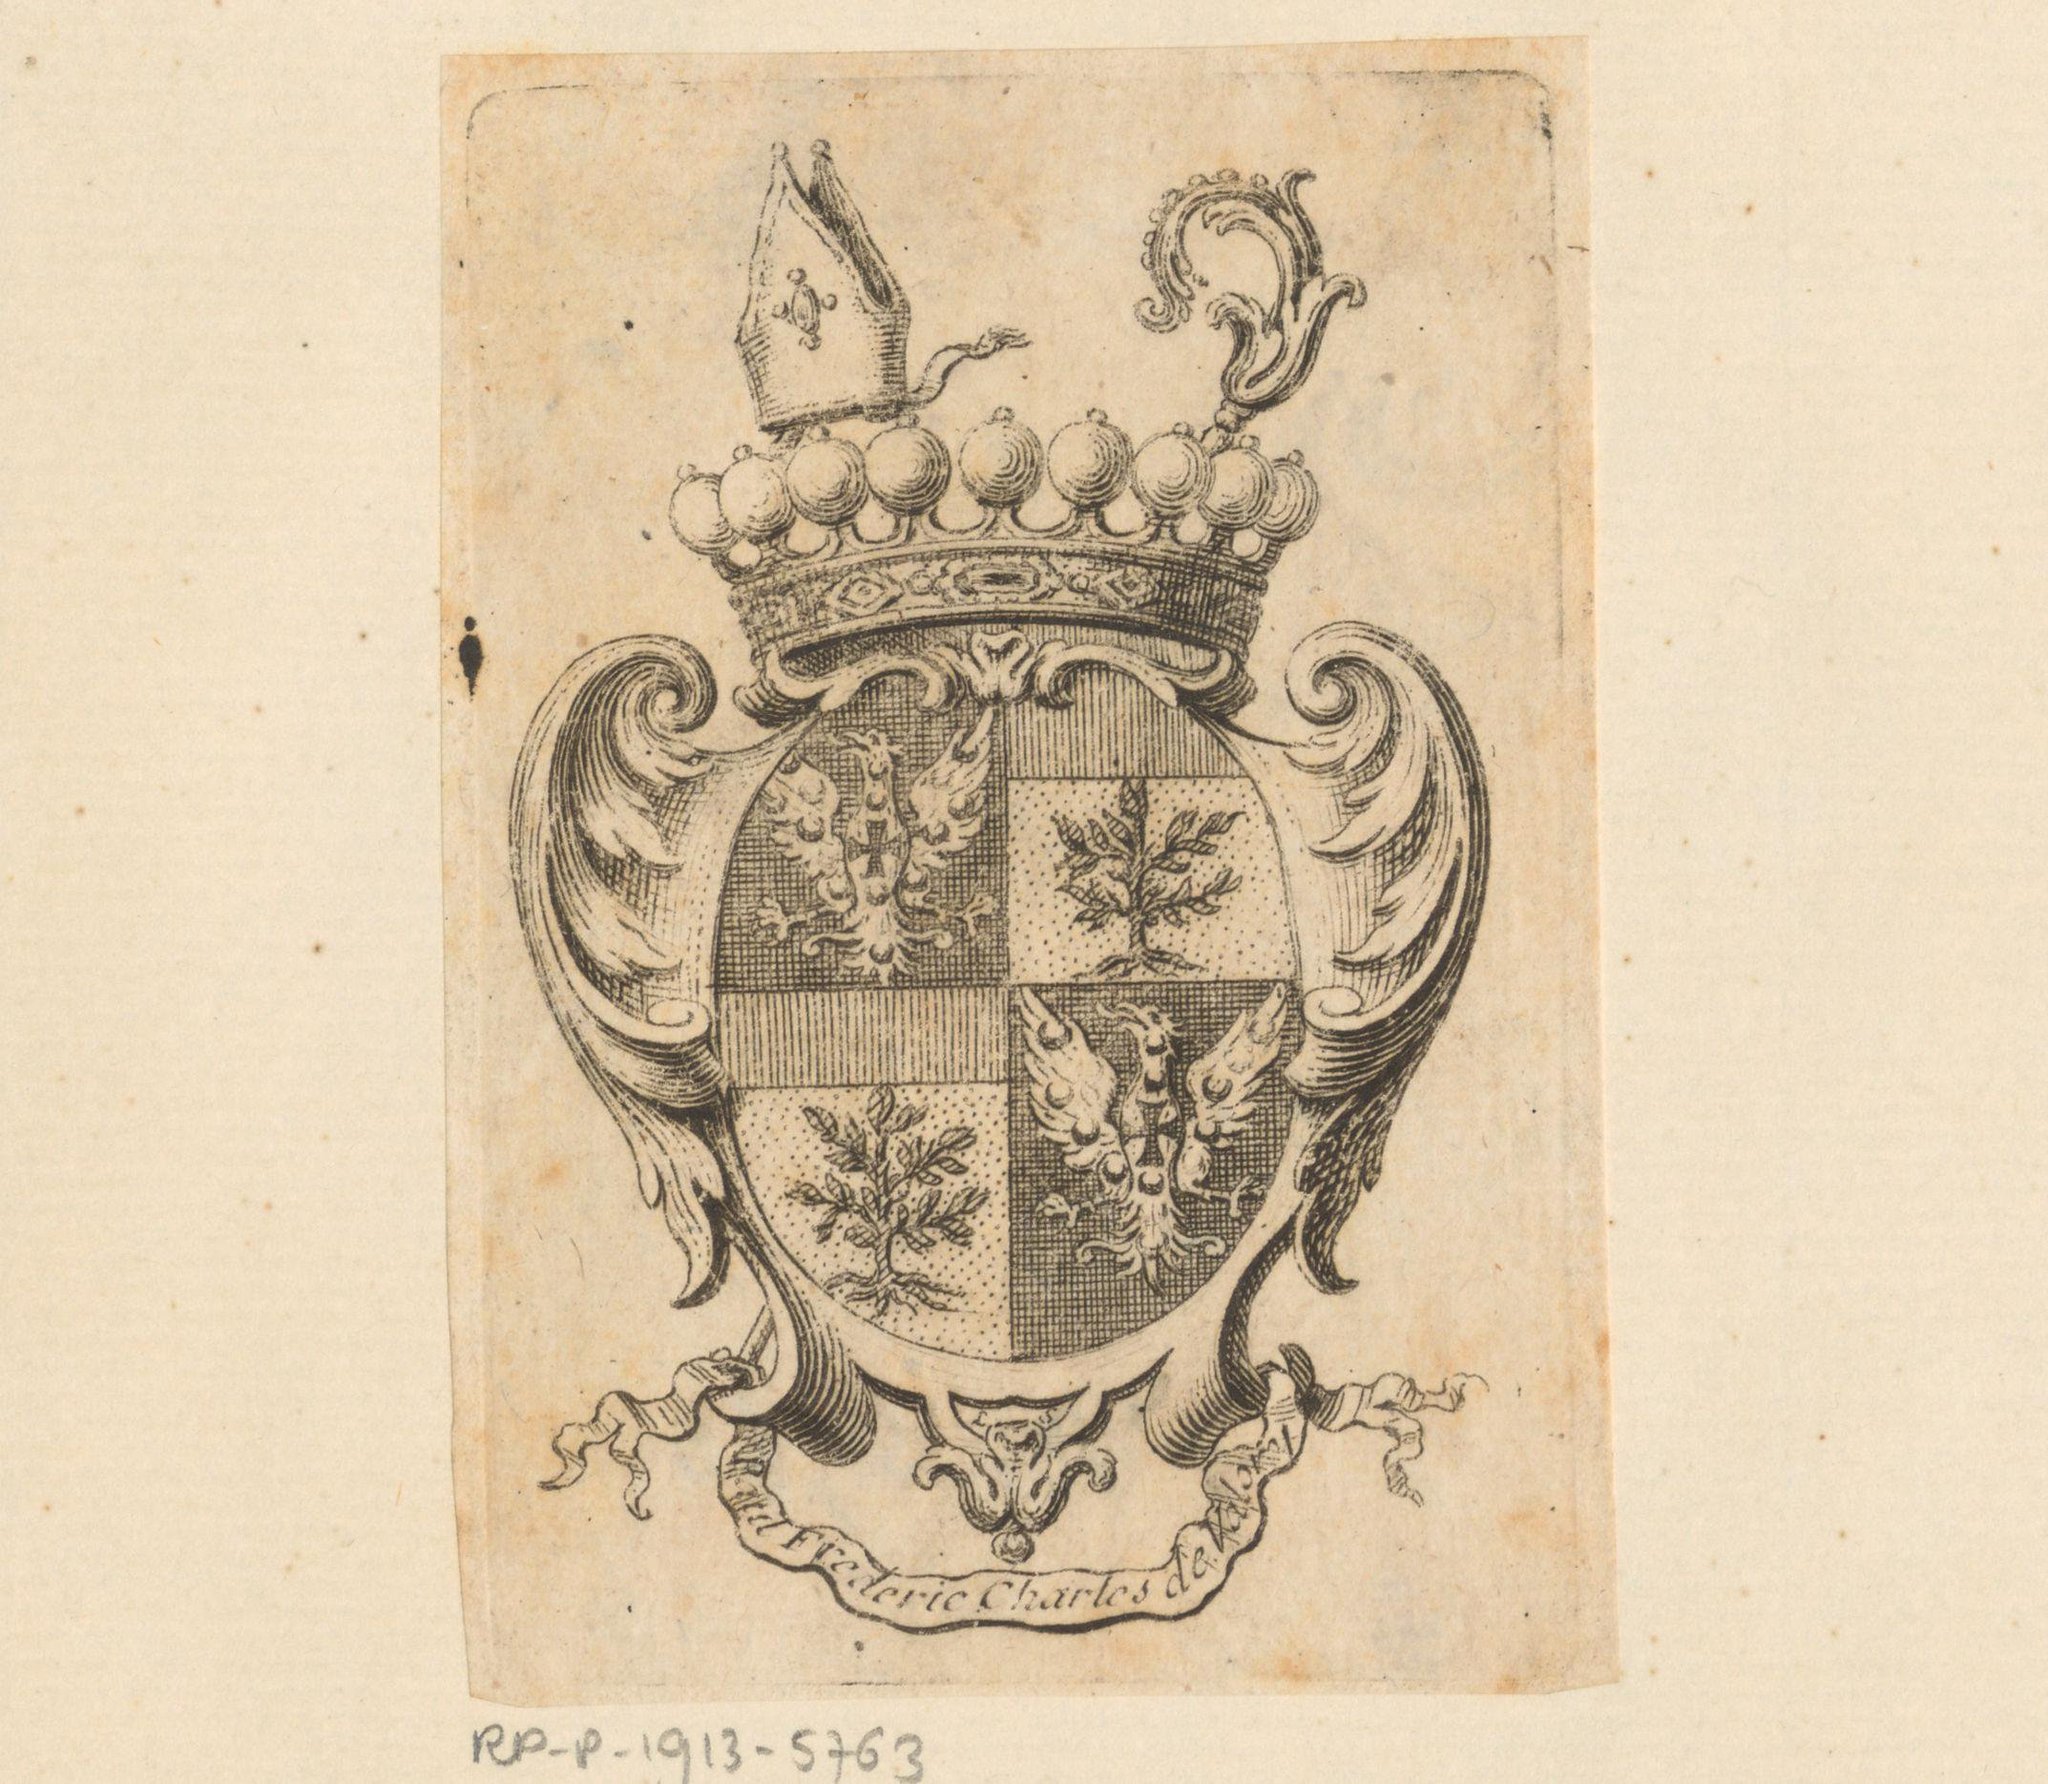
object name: bookplate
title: Ex libris van Paul-Fréderic-Charles de Valori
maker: Anonymous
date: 1692-1753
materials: paper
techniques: engraving, etching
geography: france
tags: clergyman, predatory birds: eagle, insignia of bishop, e.g. mitre, crozier, armorial bearing, heraldry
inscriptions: collector's mark: Lugt 2760, collector's mark: Lugt 2233